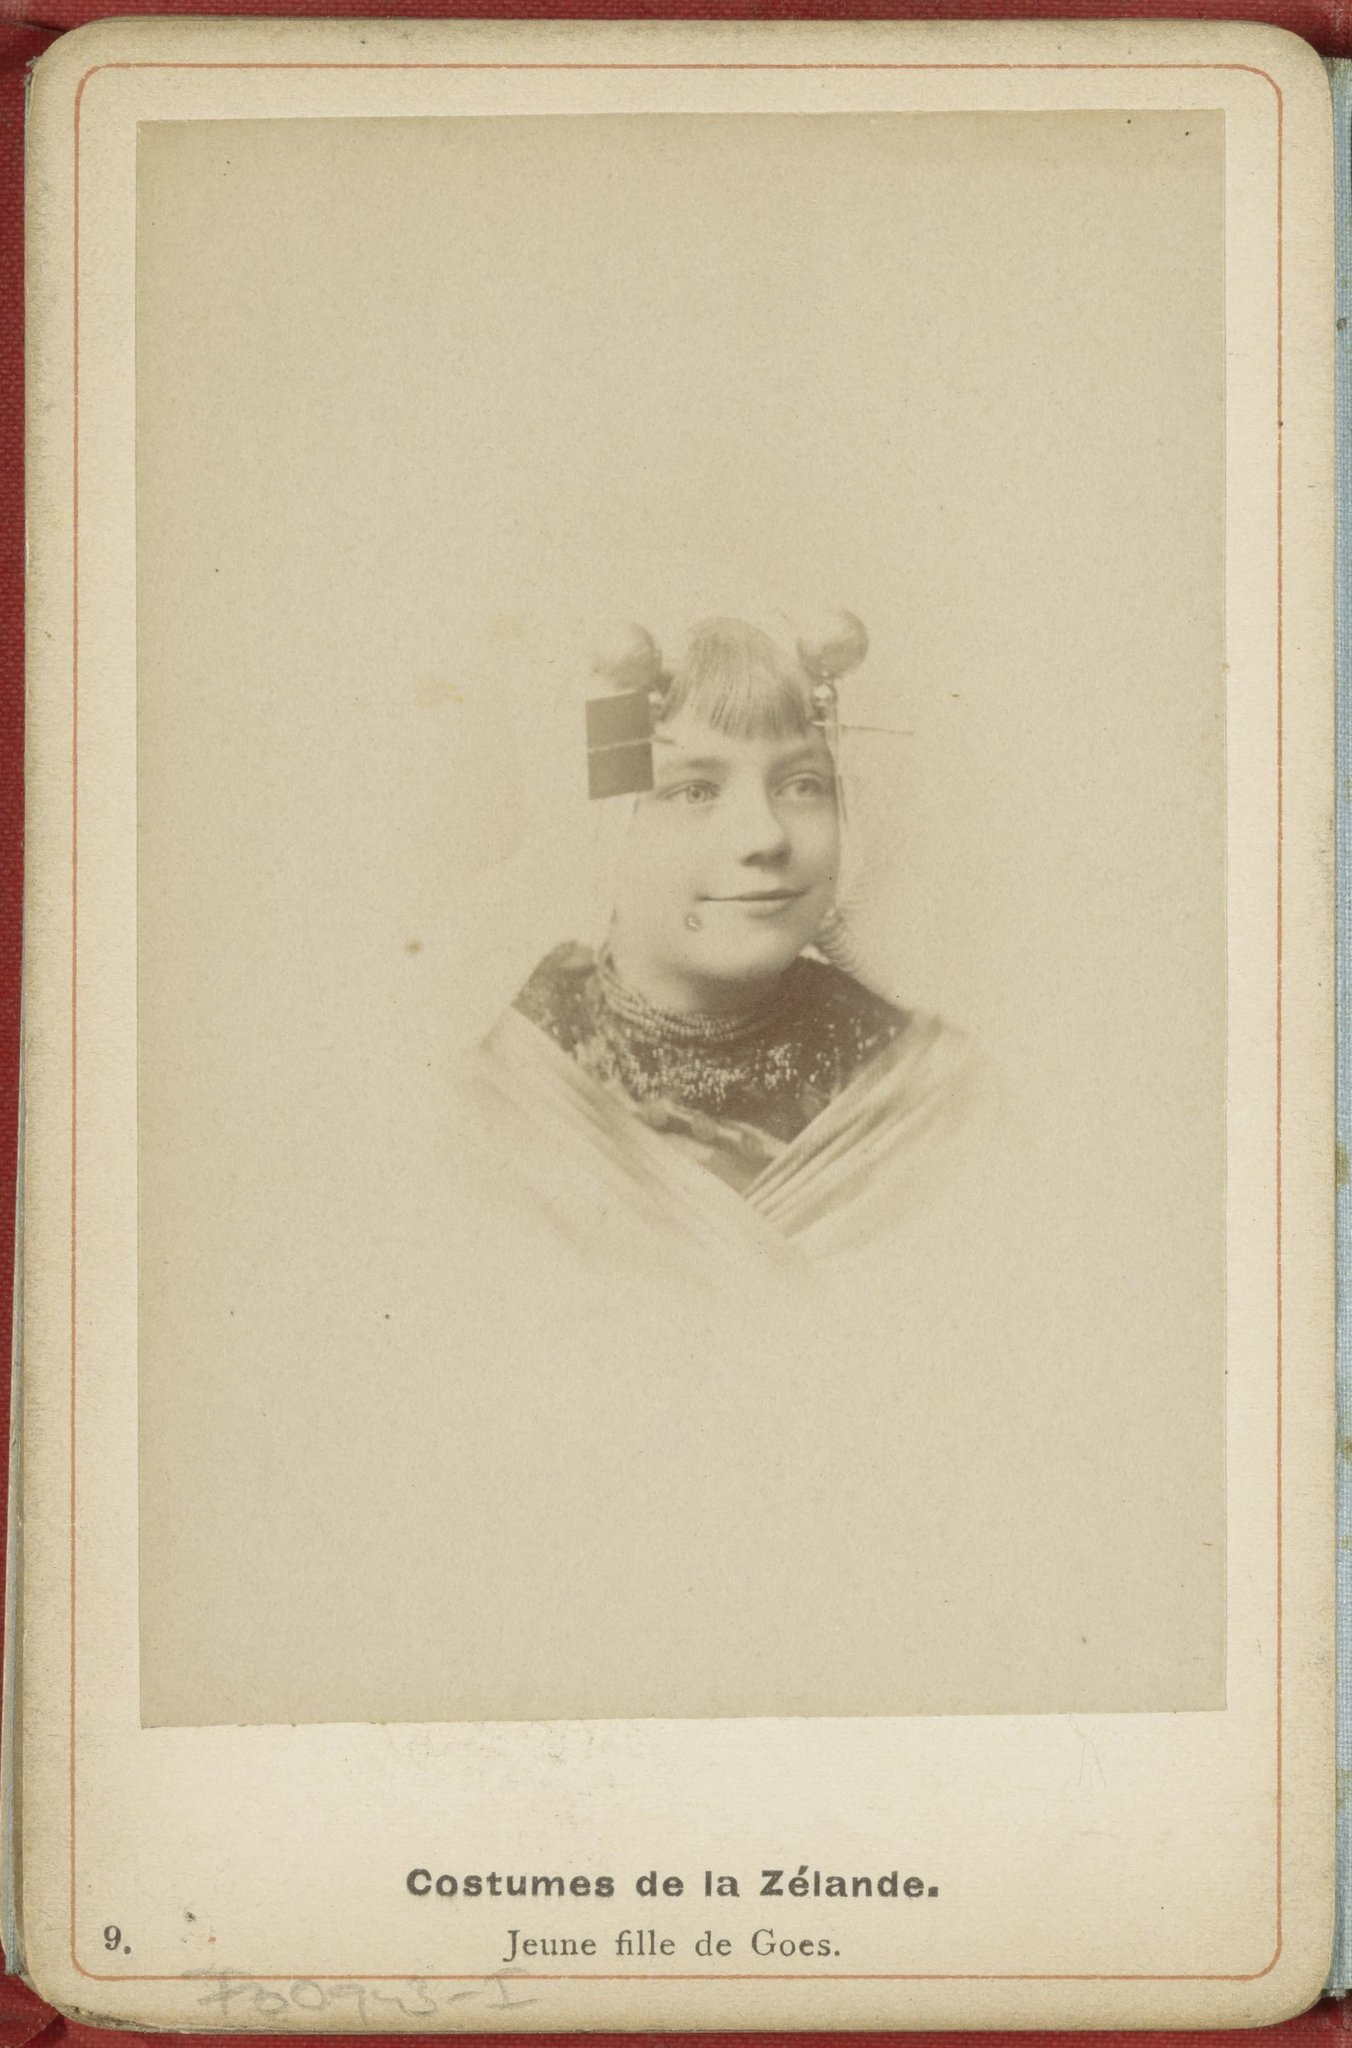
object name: photograph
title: Jeune fille de Goes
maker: Anonymous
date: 1870-1910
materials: cardboard, photographic support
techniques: albumen print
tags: folk costume, regional costume (+ women's clothes)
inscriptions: number: ‘9’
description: Onderdeel van Leporelloalbum met Zeeuwse klederdrachten.